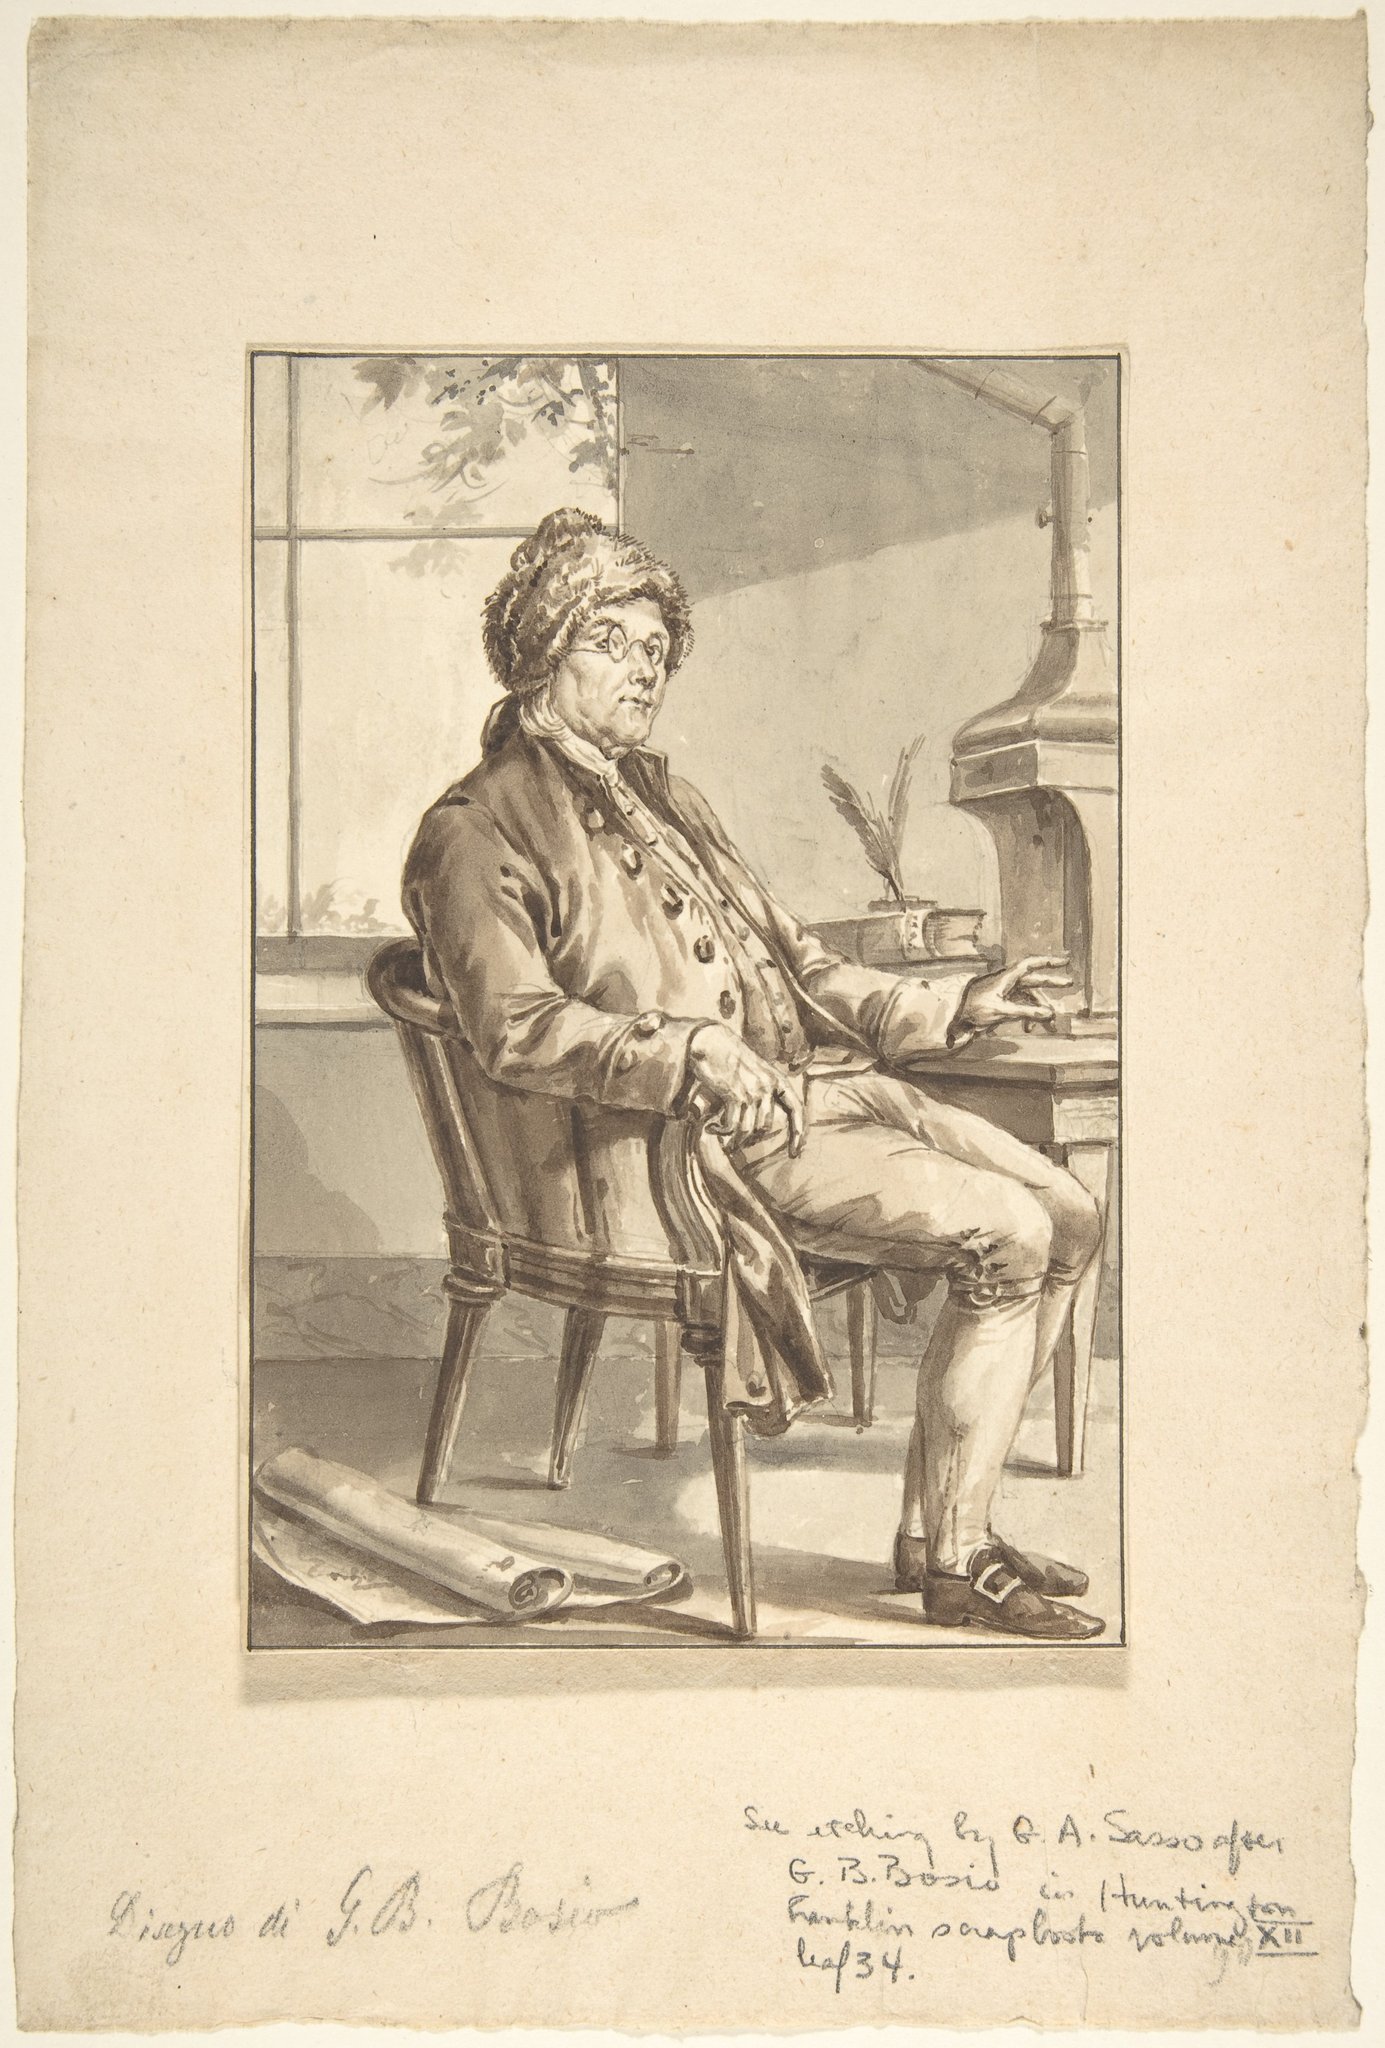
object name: drawing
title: Portrait of Benjamin Franklin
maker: jean-baptiste-françois bosio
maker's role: artist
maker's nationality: french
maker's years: 1764-1827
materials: ink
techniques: brush, pen, wash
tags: benjamin franklin,men,portraits